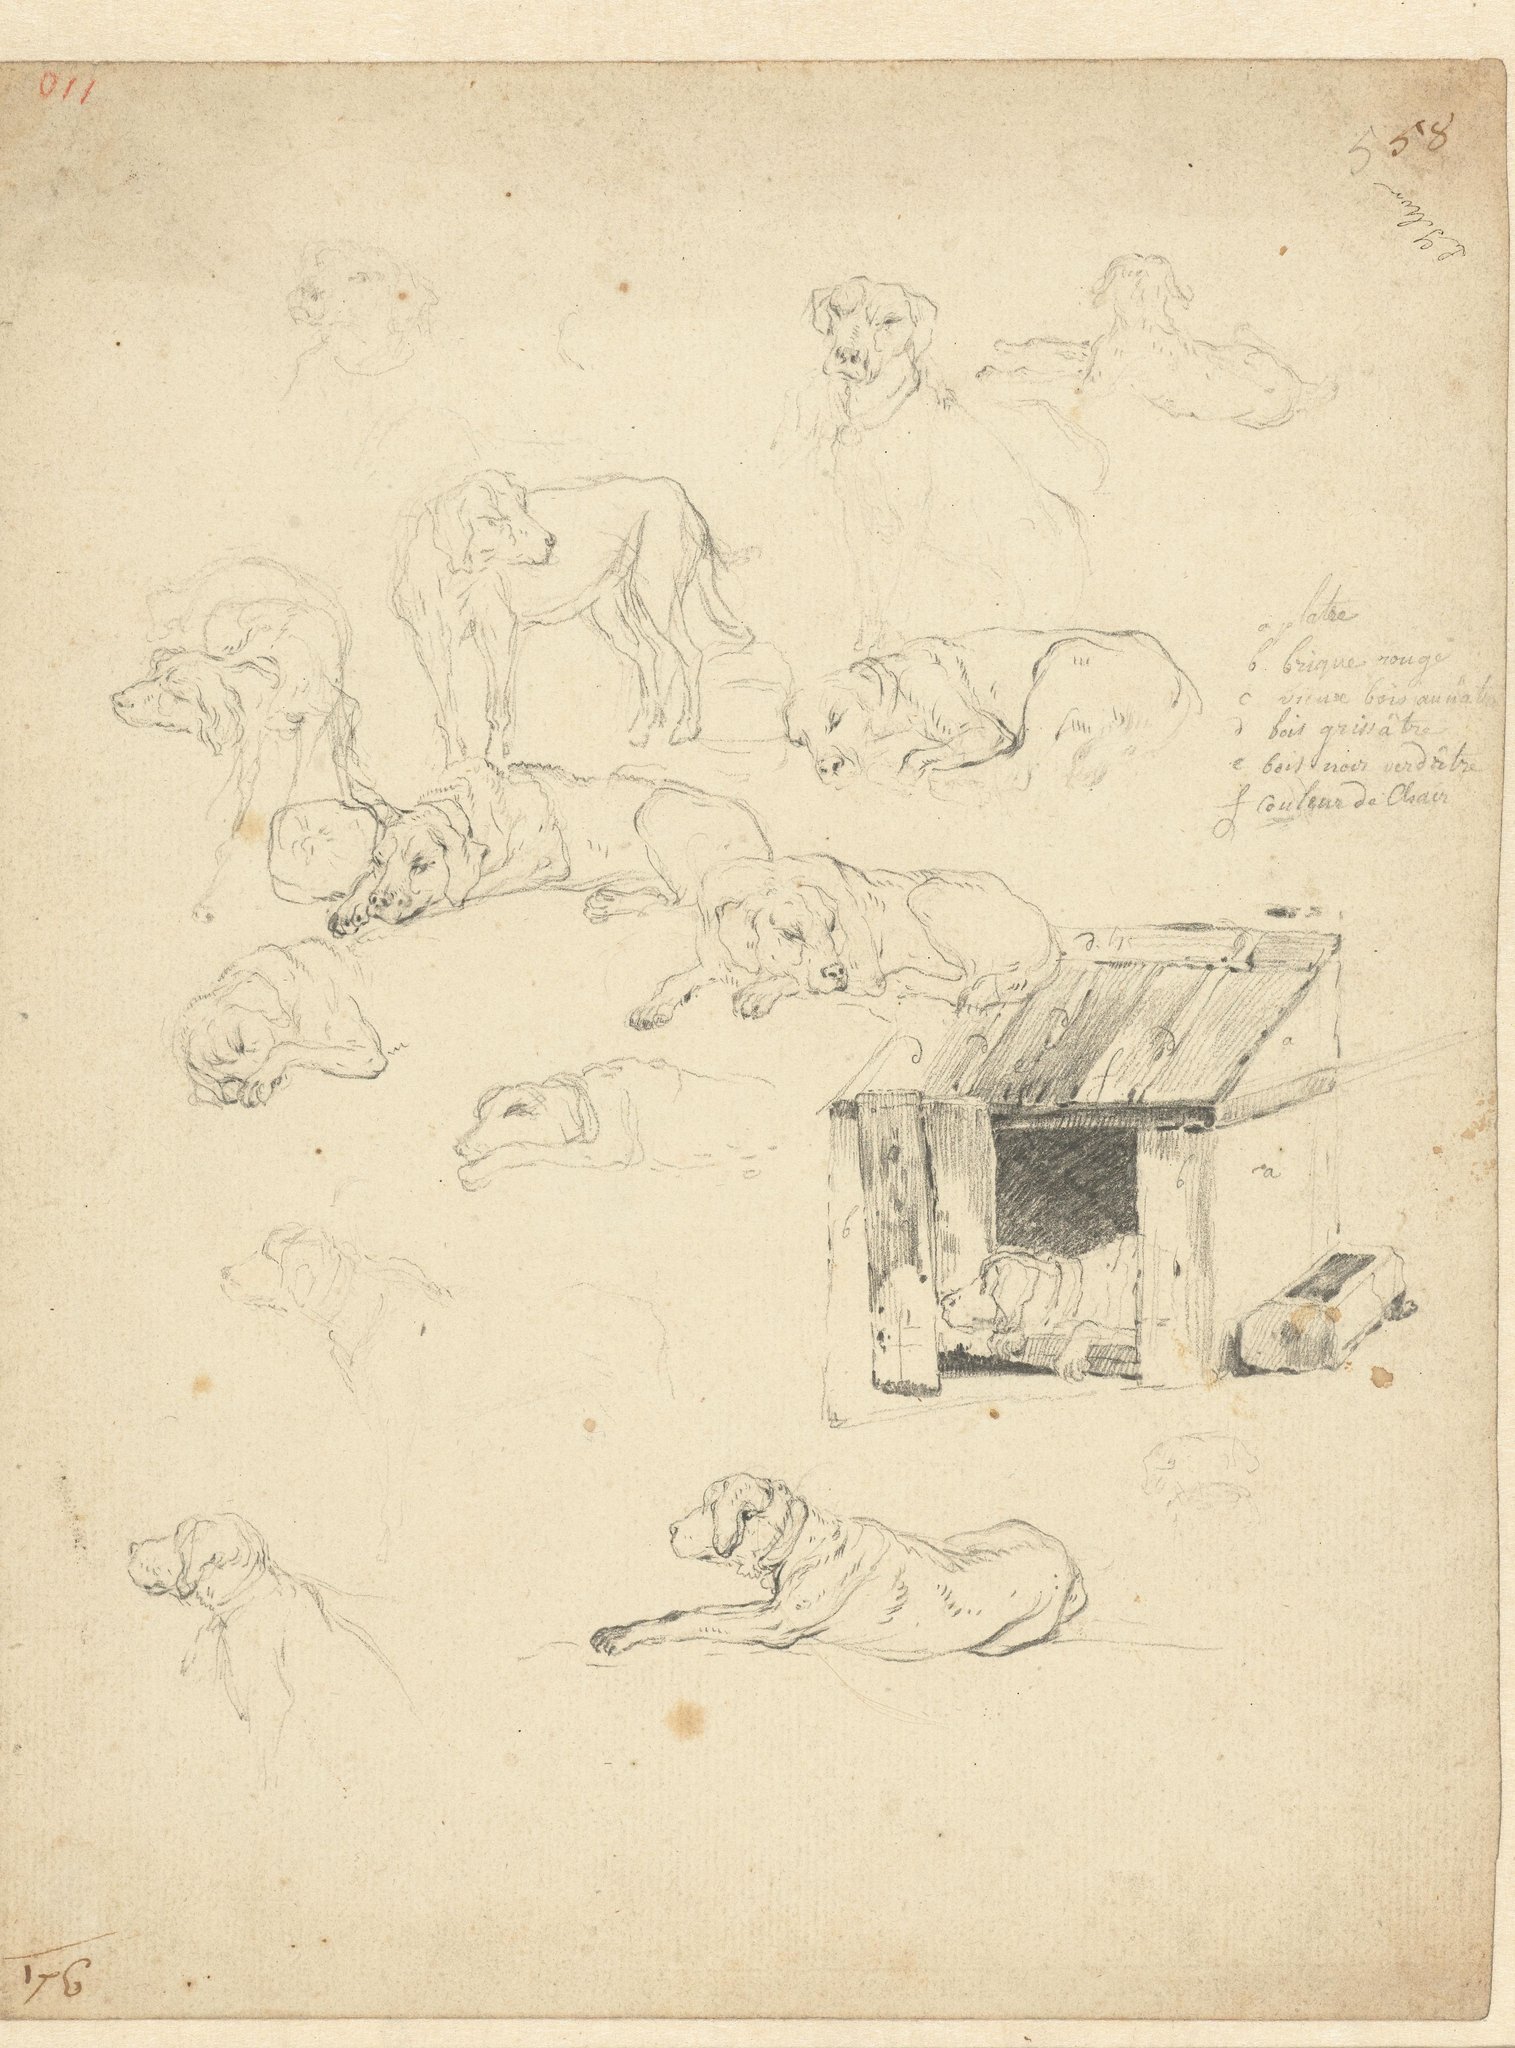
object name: drawing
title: Studies van een waakhond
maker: hendrik stokvisch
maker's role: draughtsman, painter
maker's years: 1768-1820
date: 1778-1820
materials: paper, pencil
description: Studies van een waakhond, met notities in het Frans ernaast.